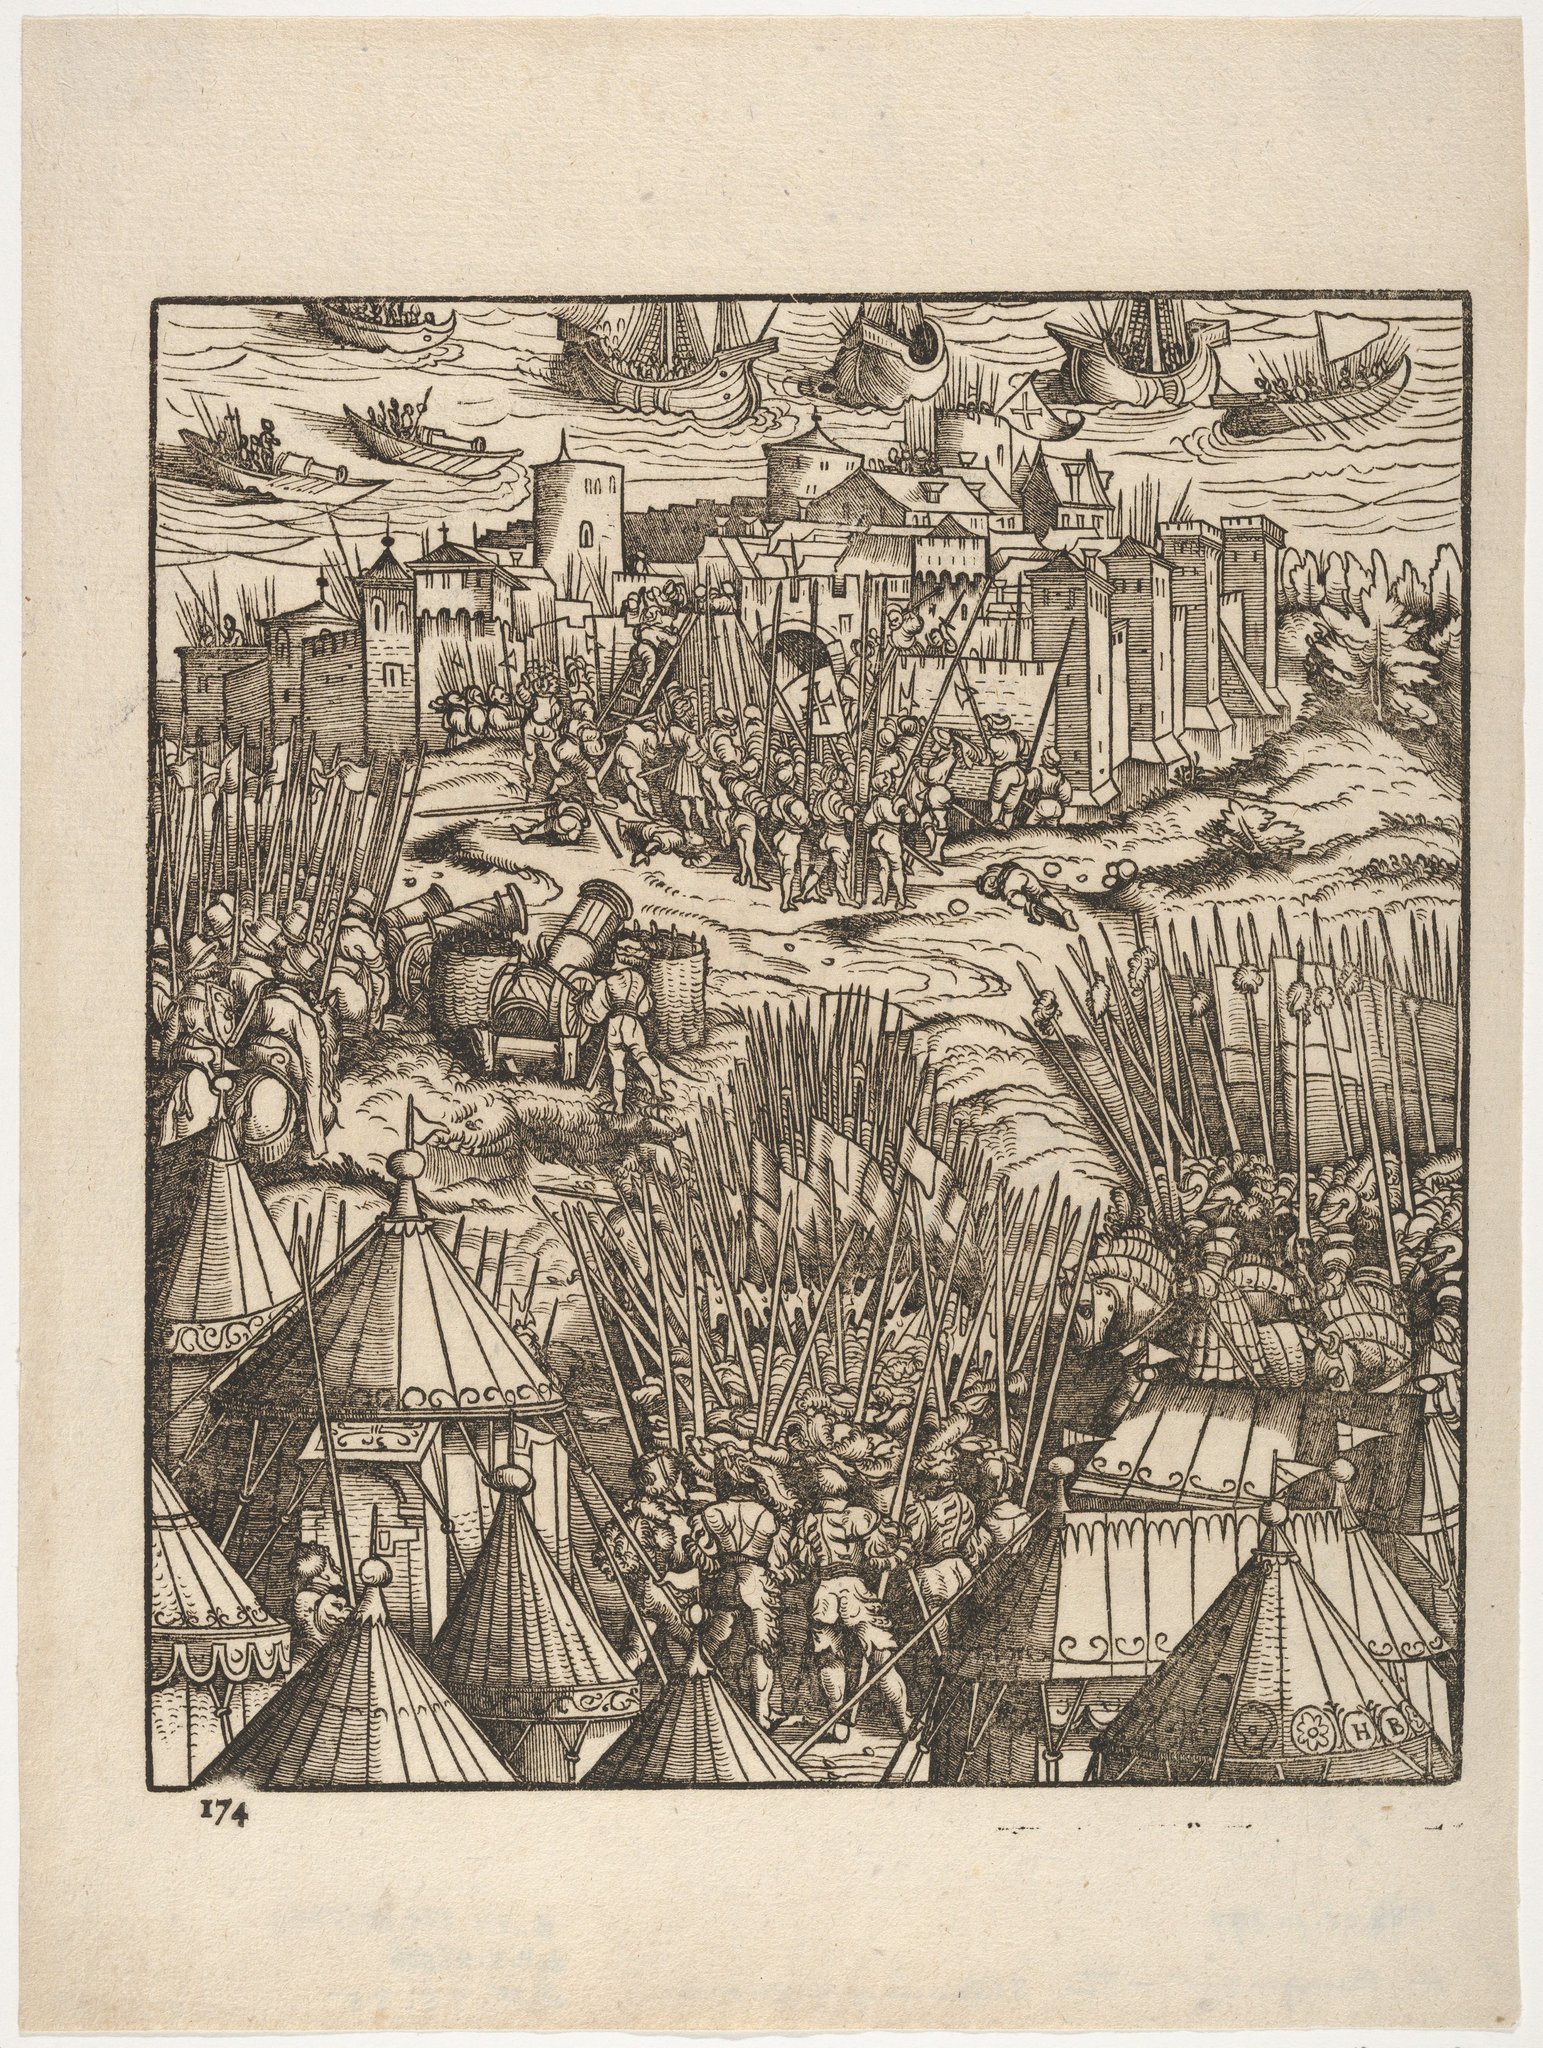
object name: print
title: Storming of Moran, at the Shore, from "Der Weisskunig"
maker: hans burgkmair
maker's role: artist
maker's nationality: german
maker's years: 1473-1531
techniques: woodcut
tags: castles,battles,soldiers,horses,boats